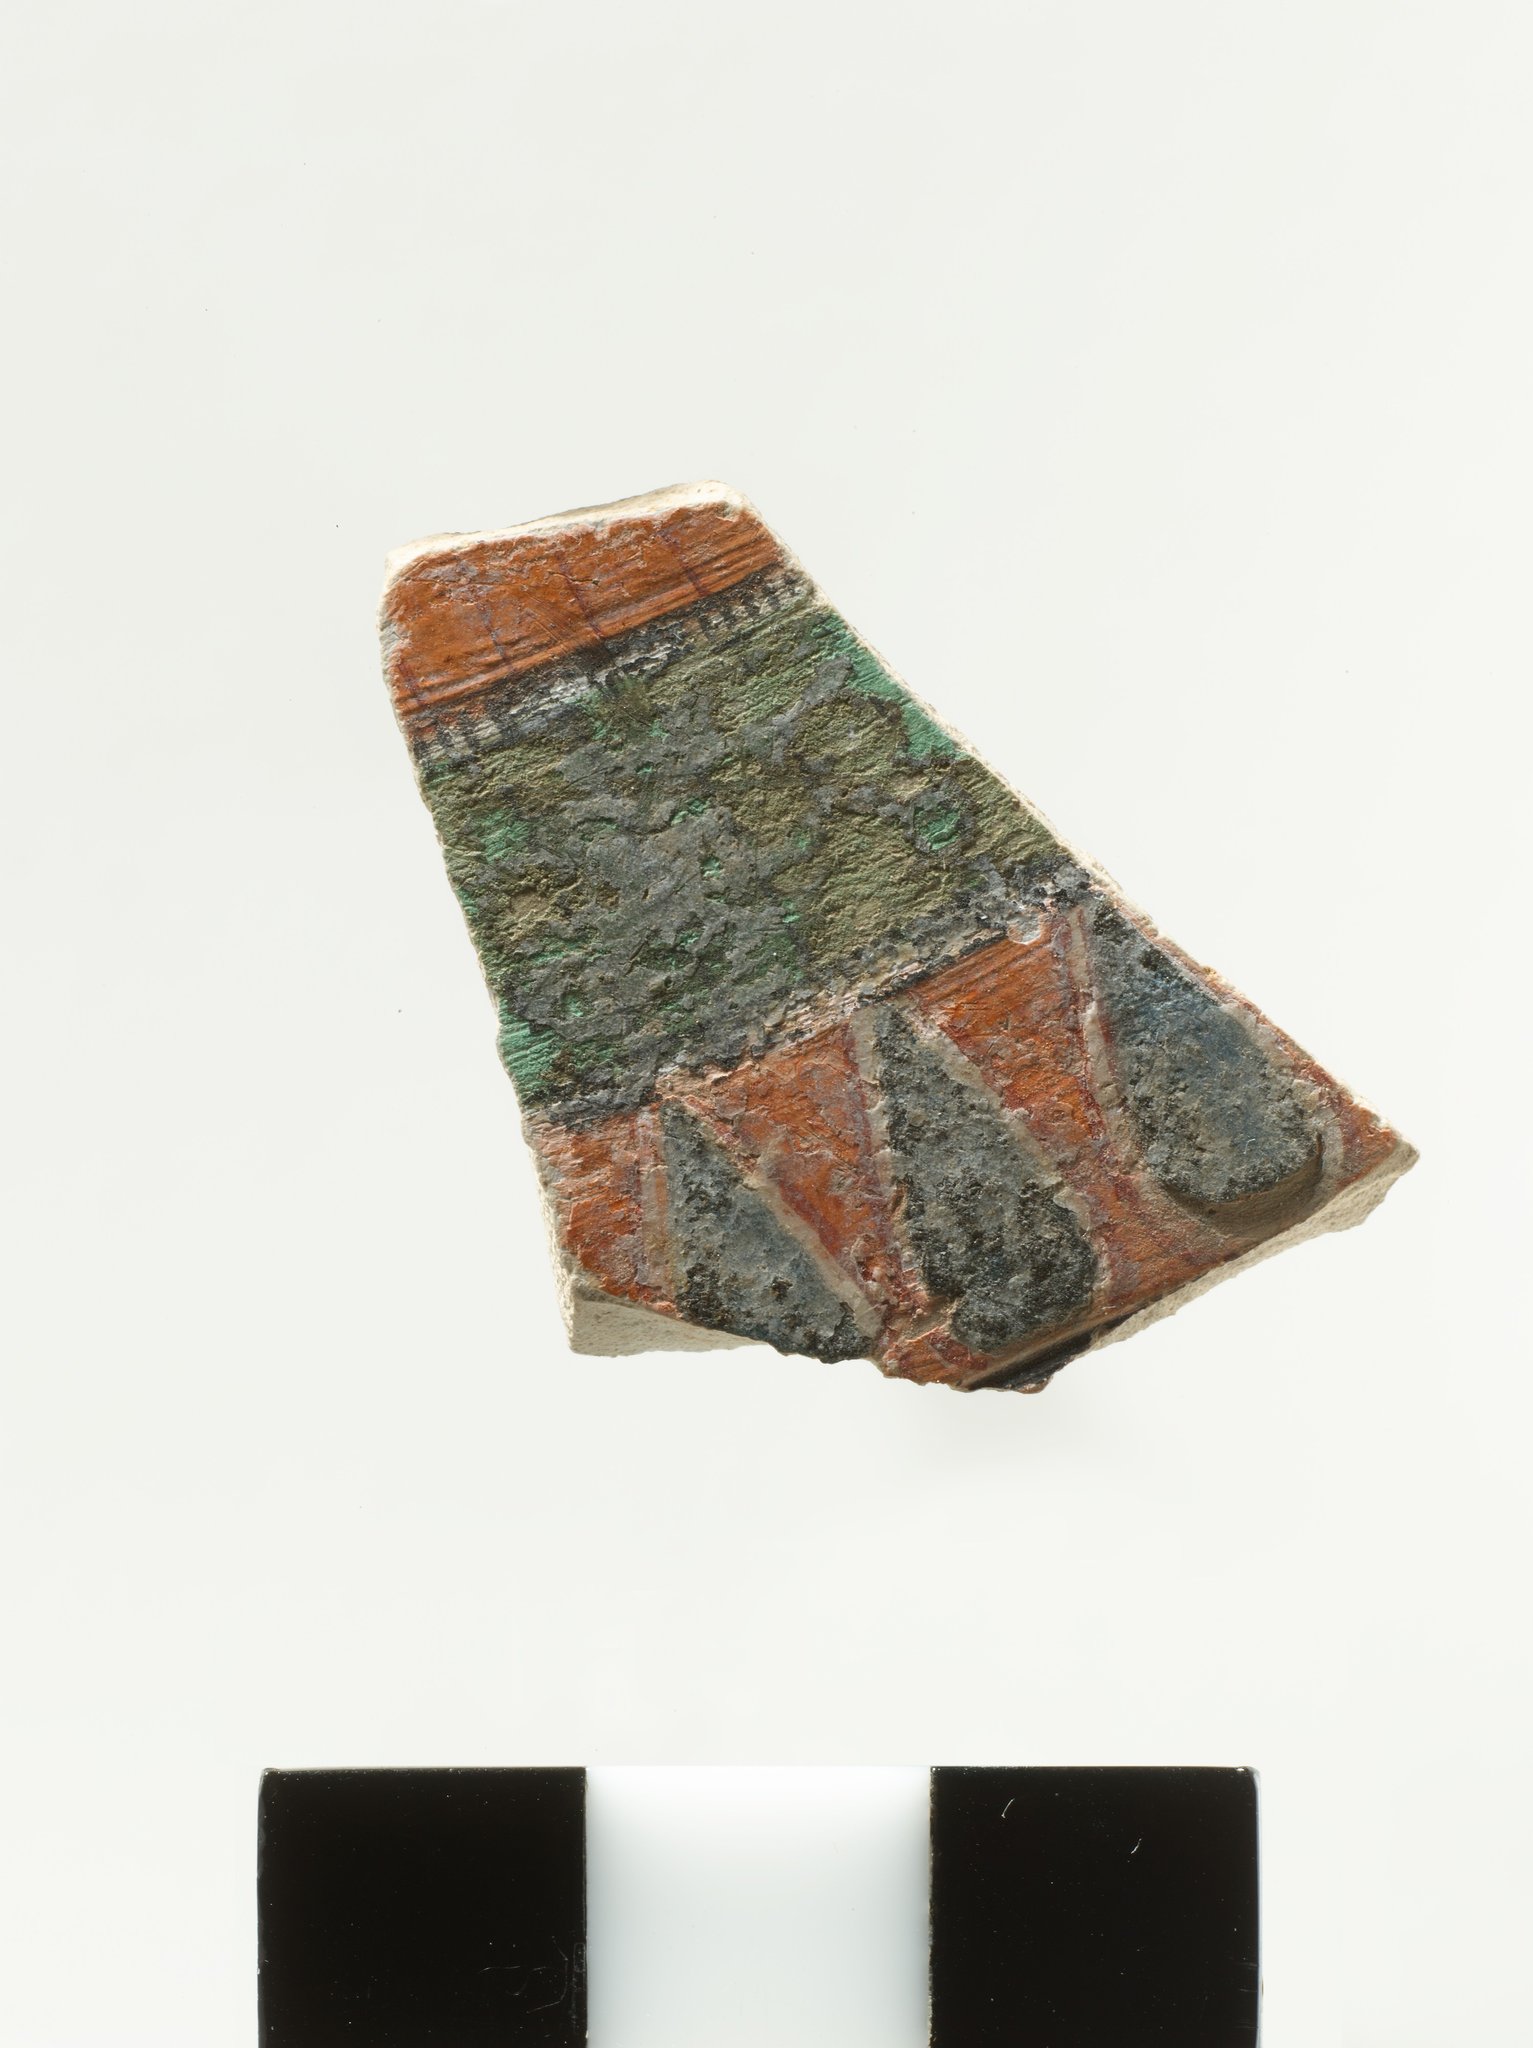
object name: relief fragment, tomb of meketre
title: Reliefs from the tomb of Meketre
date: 1981-1975 BCE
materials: limestone, paint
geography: egypt